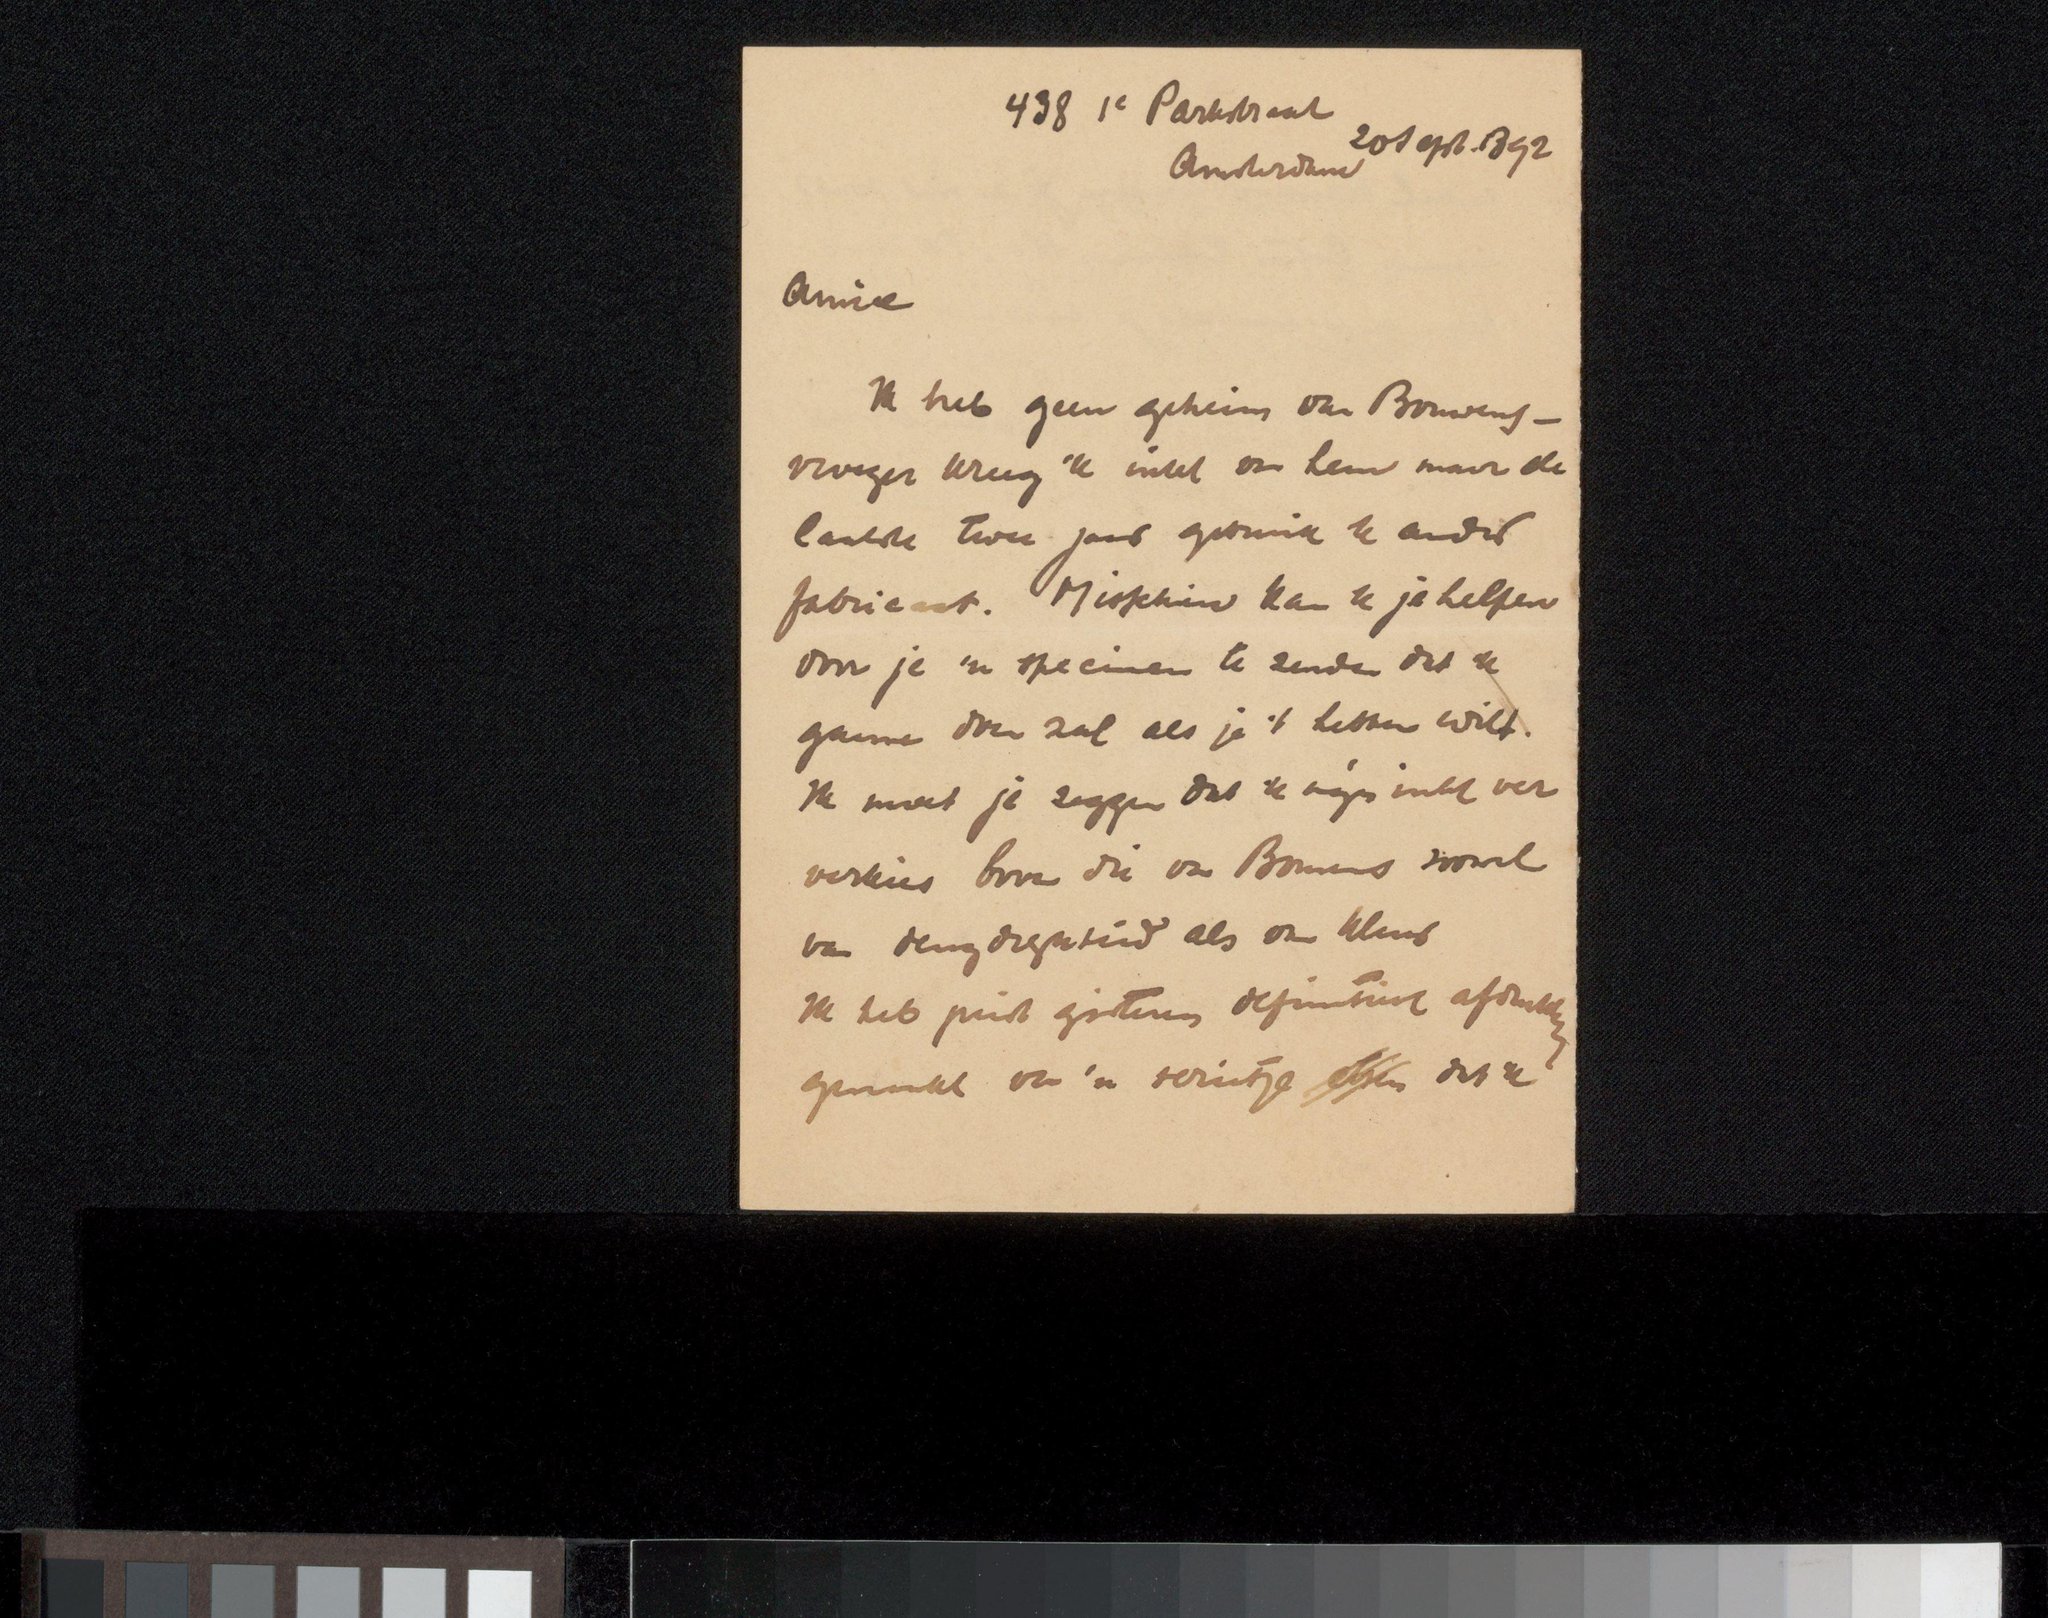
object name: letter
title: Brief aan Philip Zilcken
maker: willem witsen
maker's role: draughtsman, painter, print maker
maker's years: 1860-1923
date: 1892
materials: ink, paper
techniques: pen, writing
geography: amsterdam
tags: dordrecht, jan veth, printer, joseph bouwens, the hague, philip zilcken, the graphic arts, london, amsterdam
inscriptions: collector's mark: ‘RPK’